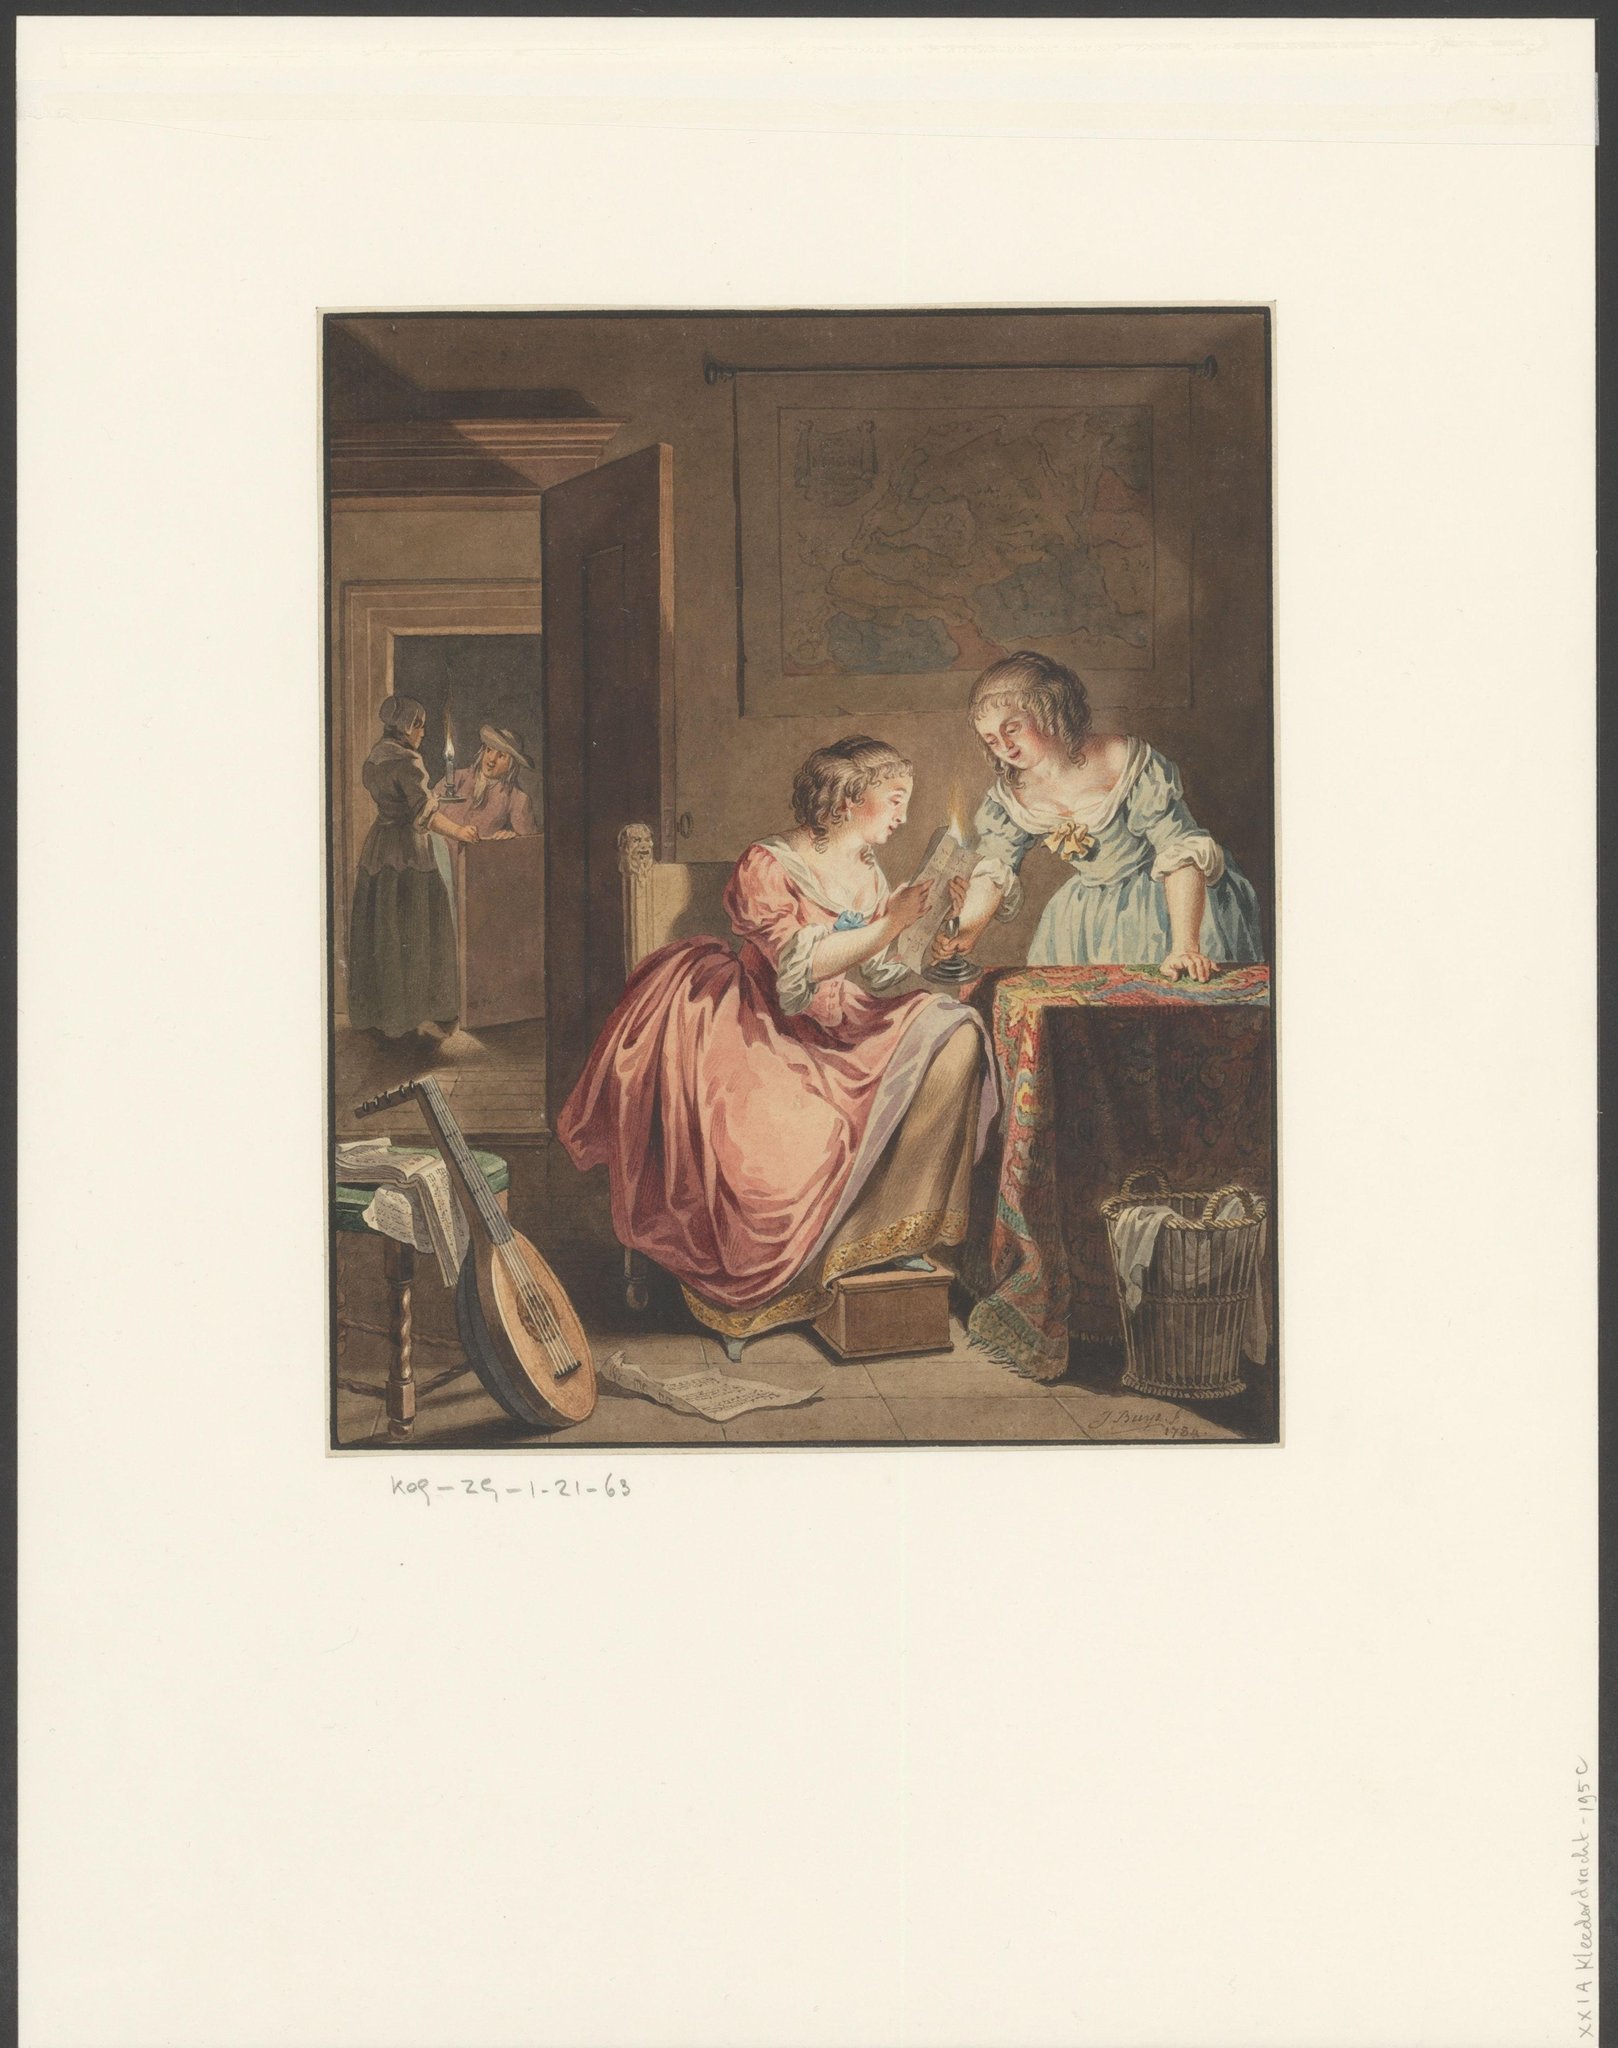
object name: drawing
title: Twee vrouwen lezen een brief bij kaarslicht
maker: jacobus buys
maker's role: draughtsman, print maker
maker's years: 1724-1801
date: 1784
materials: ink, paper, watercolor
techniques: brush, pen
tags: lute, and special forms of lute, e.g.: theorbo, lover with love-letter, (map of) europe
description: Twee vrouwen lezen een brief bij kaarslicht. Een warmt haar voeten op een stoof. Links staat een kruk met bladmuziek met een luit er tegenaan. Achterin laat een vrouw een man binnen. Onderwerpsrubrieken binnen de Atlas Zeden en Gewoonten: Zeden en Gewoonten in Engeren Zin, De Kleeding, Kleederdrachten (tijdvakken), De 18de eeuw (de pruikentijd). Mannen en vrouwen.